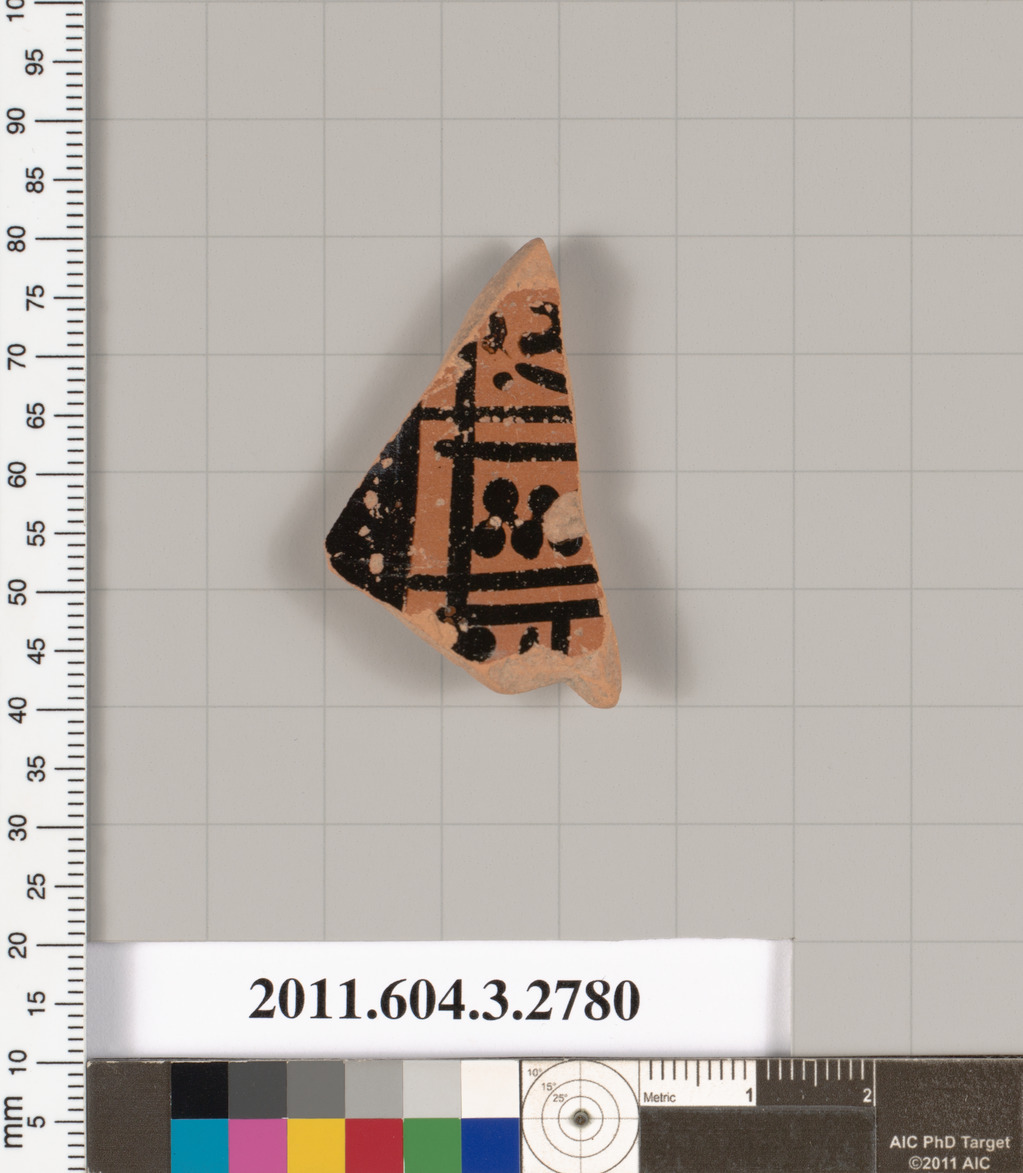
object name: olpe fragment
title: Terracotta fragment of an olpe (jug)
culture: greek, attic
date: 525-501 BCE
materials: terracotta